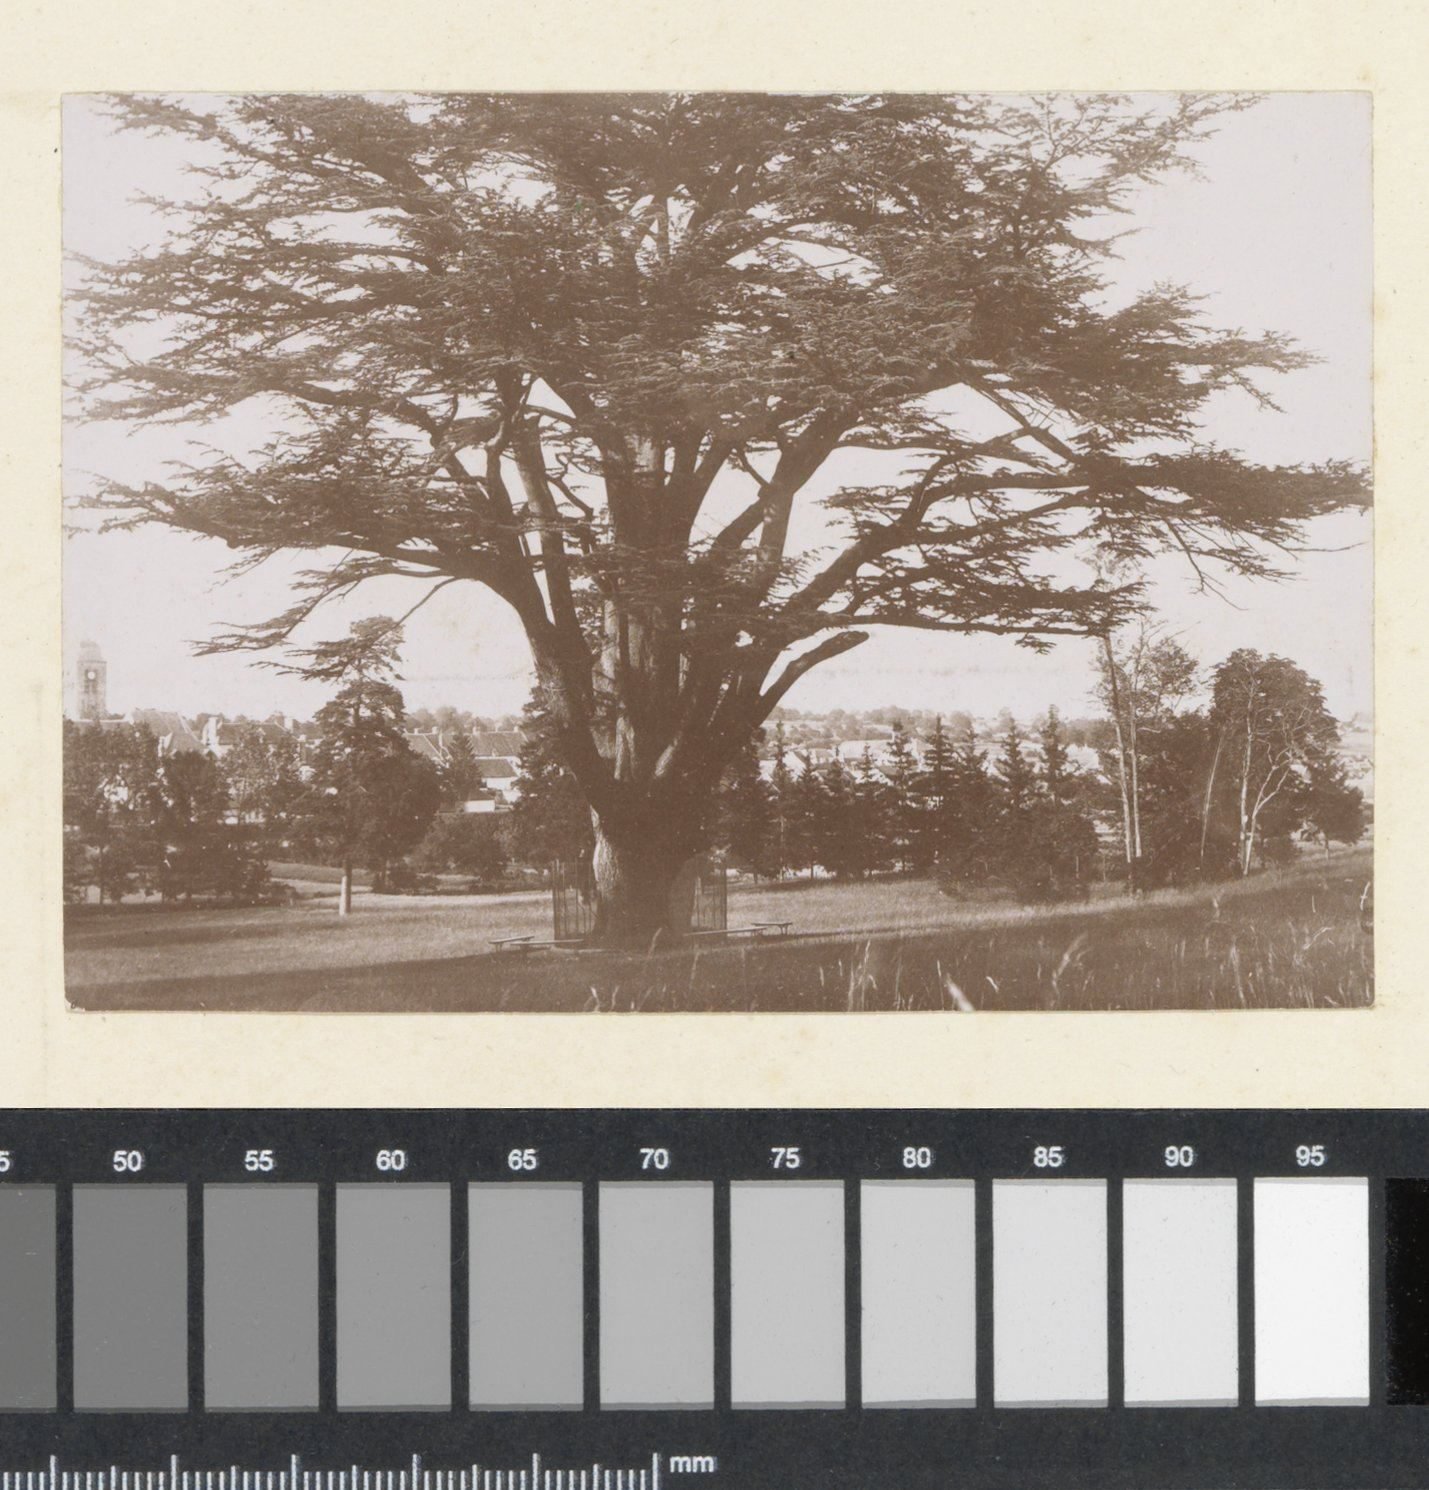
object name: photograph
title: Boom met op de achtergrond een Frans dorp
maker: Anonymous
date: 1900-1910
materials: paper, photographic support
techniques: daylight paper print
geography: france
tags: prospect of village, silhouette of village, trees, france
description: Onderdeel van Fotoalbum van een Franse amateurfotograaf met opnames van een familie, distilleerderij Delizy & Doistau Fils, het leger en bezienswaardigheden in Frankrijk.